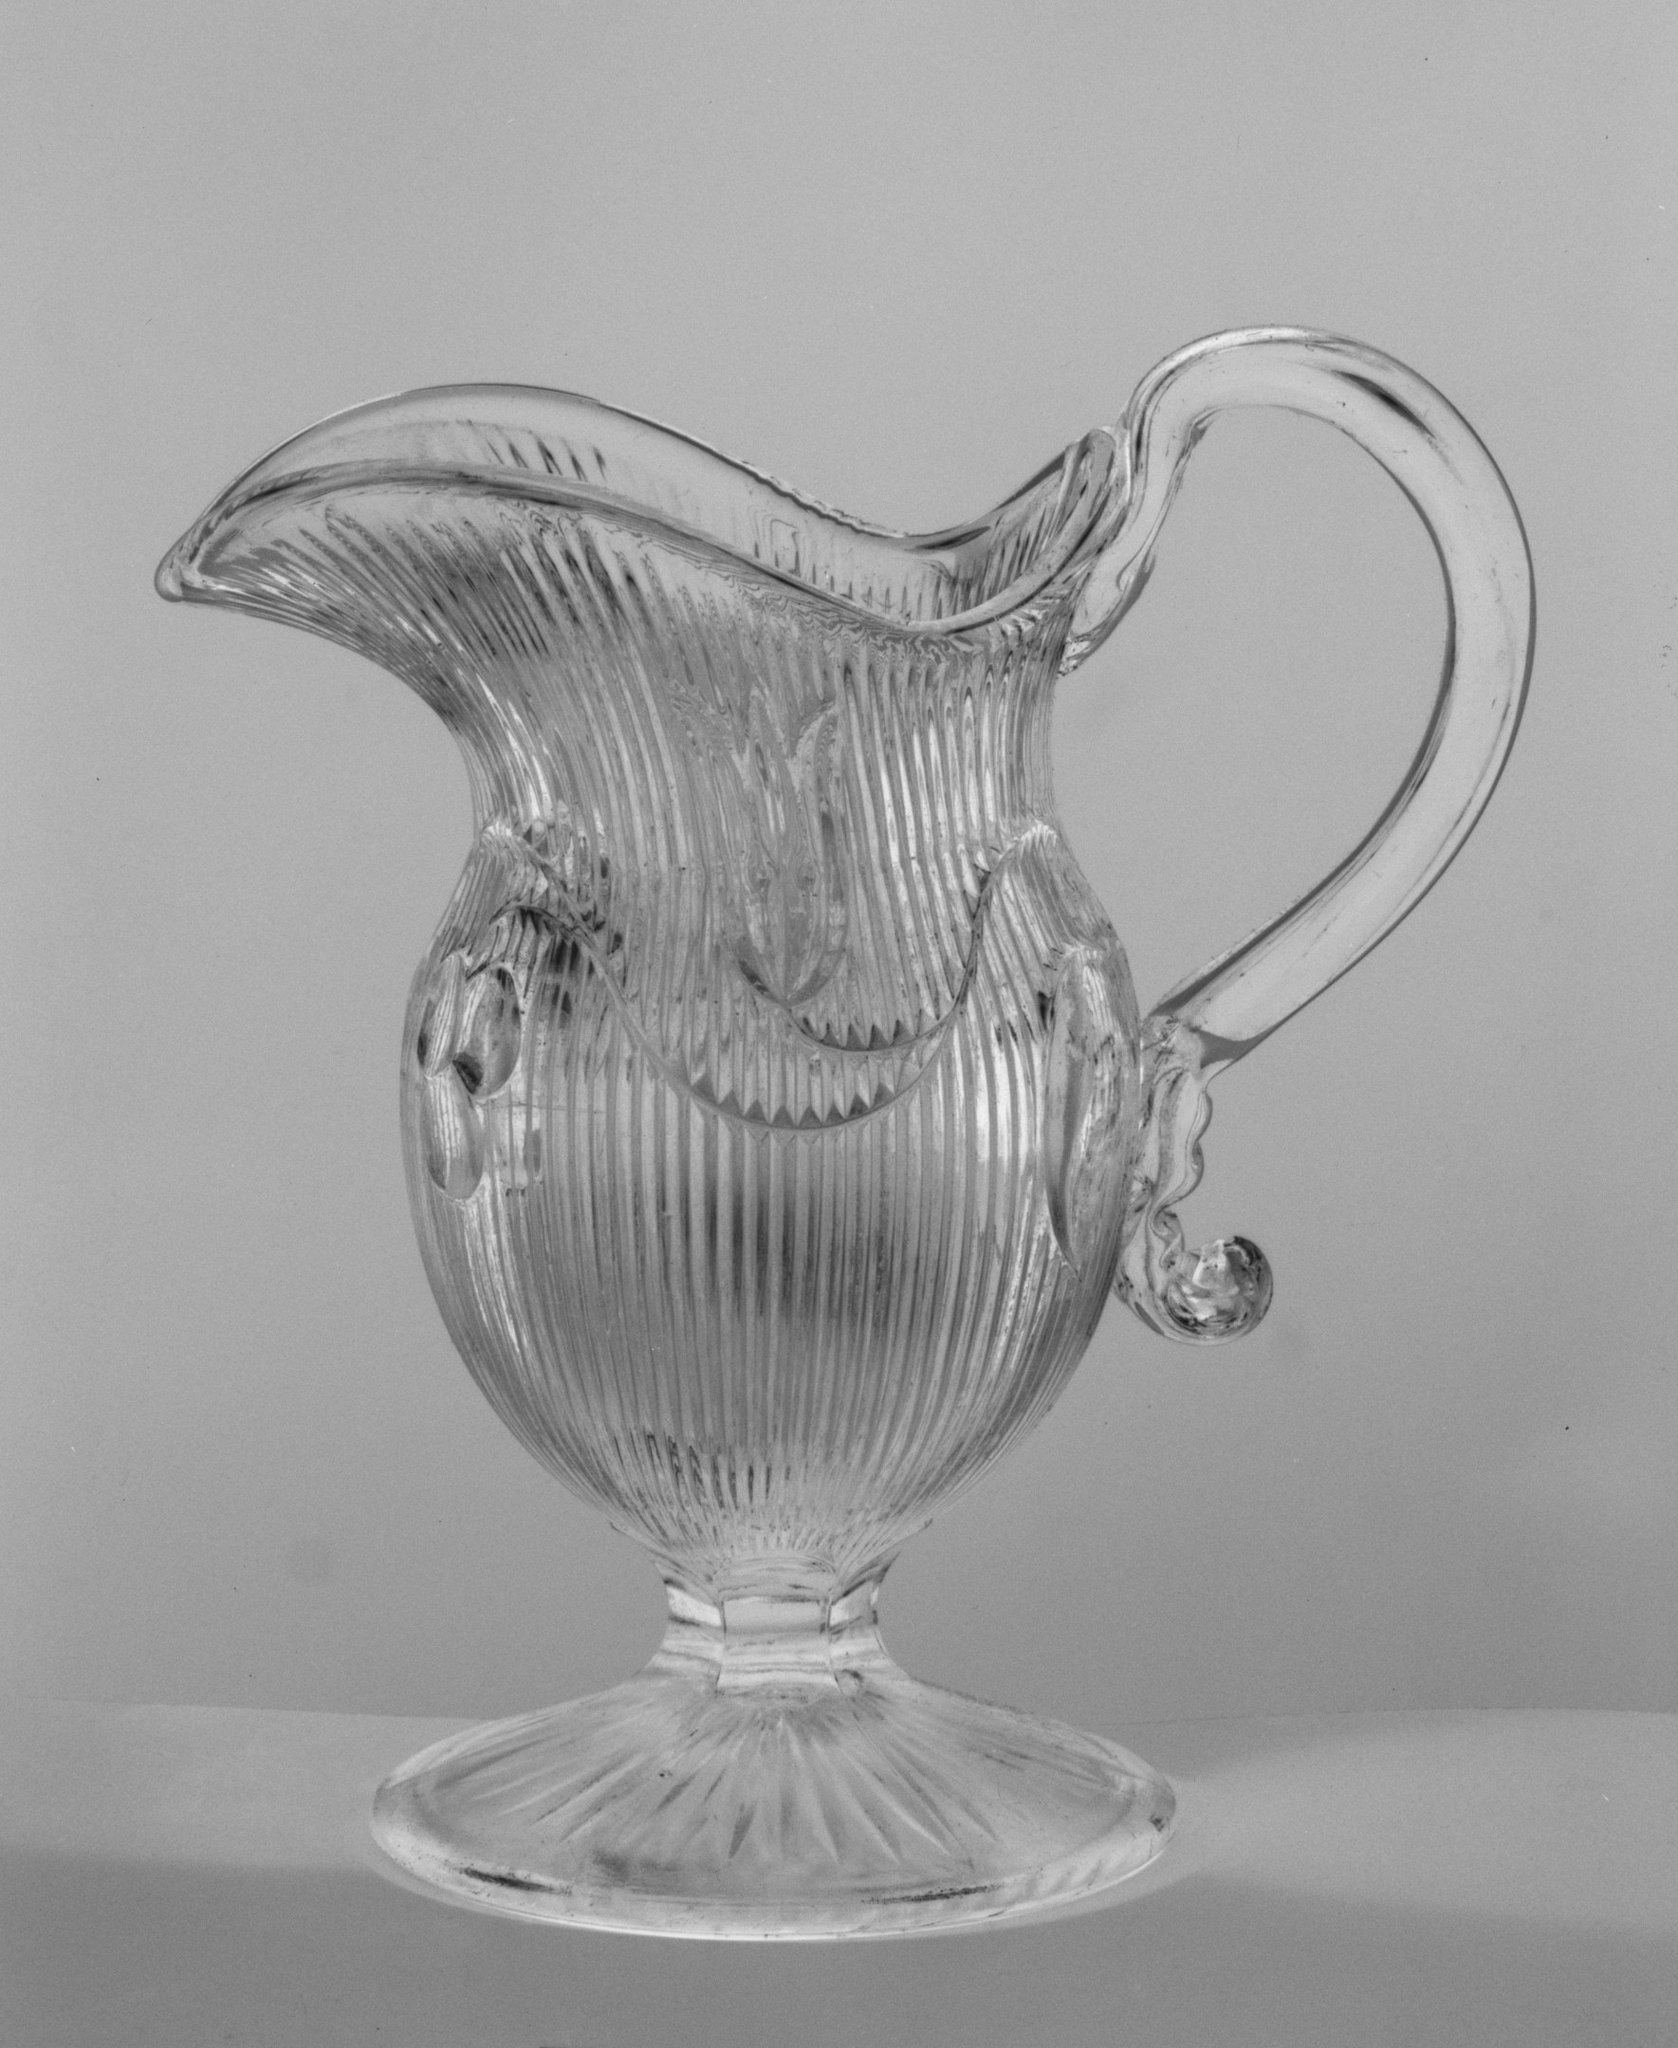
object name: cream pot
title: Creamer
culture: american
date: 1850-1870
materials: glass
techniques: pressed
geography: united states